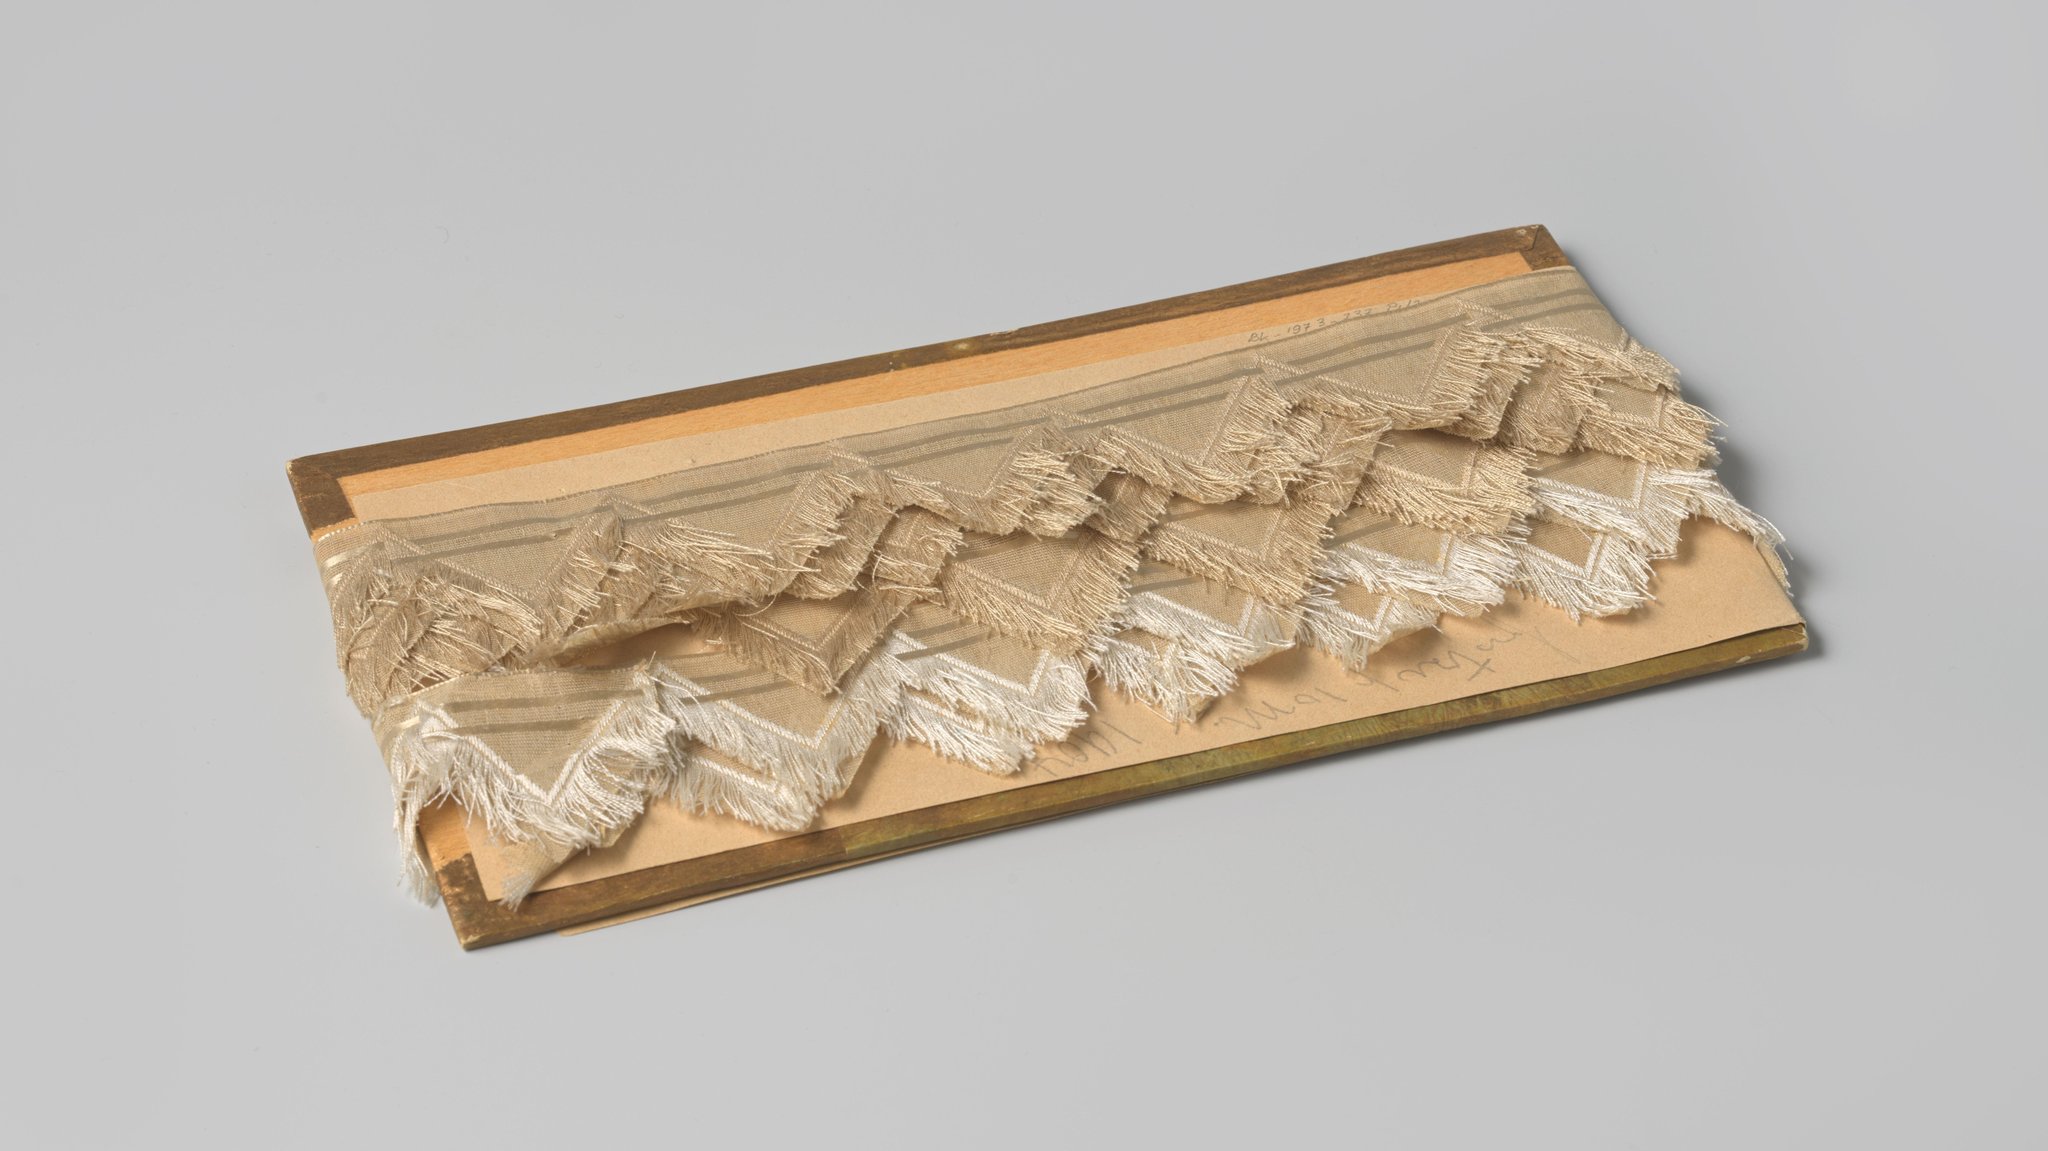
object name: strip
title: Strook franje, getand, écru, gewikkeld rond een met gouden randen afgezet plankje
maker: gustav schnitzler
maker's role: paraplufabrikant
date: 1925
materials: silk, wood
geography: nijmegen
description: Metrages kant en passement, in wit en zwart en andere kleuren. Karton met witte en beige puntfranje.